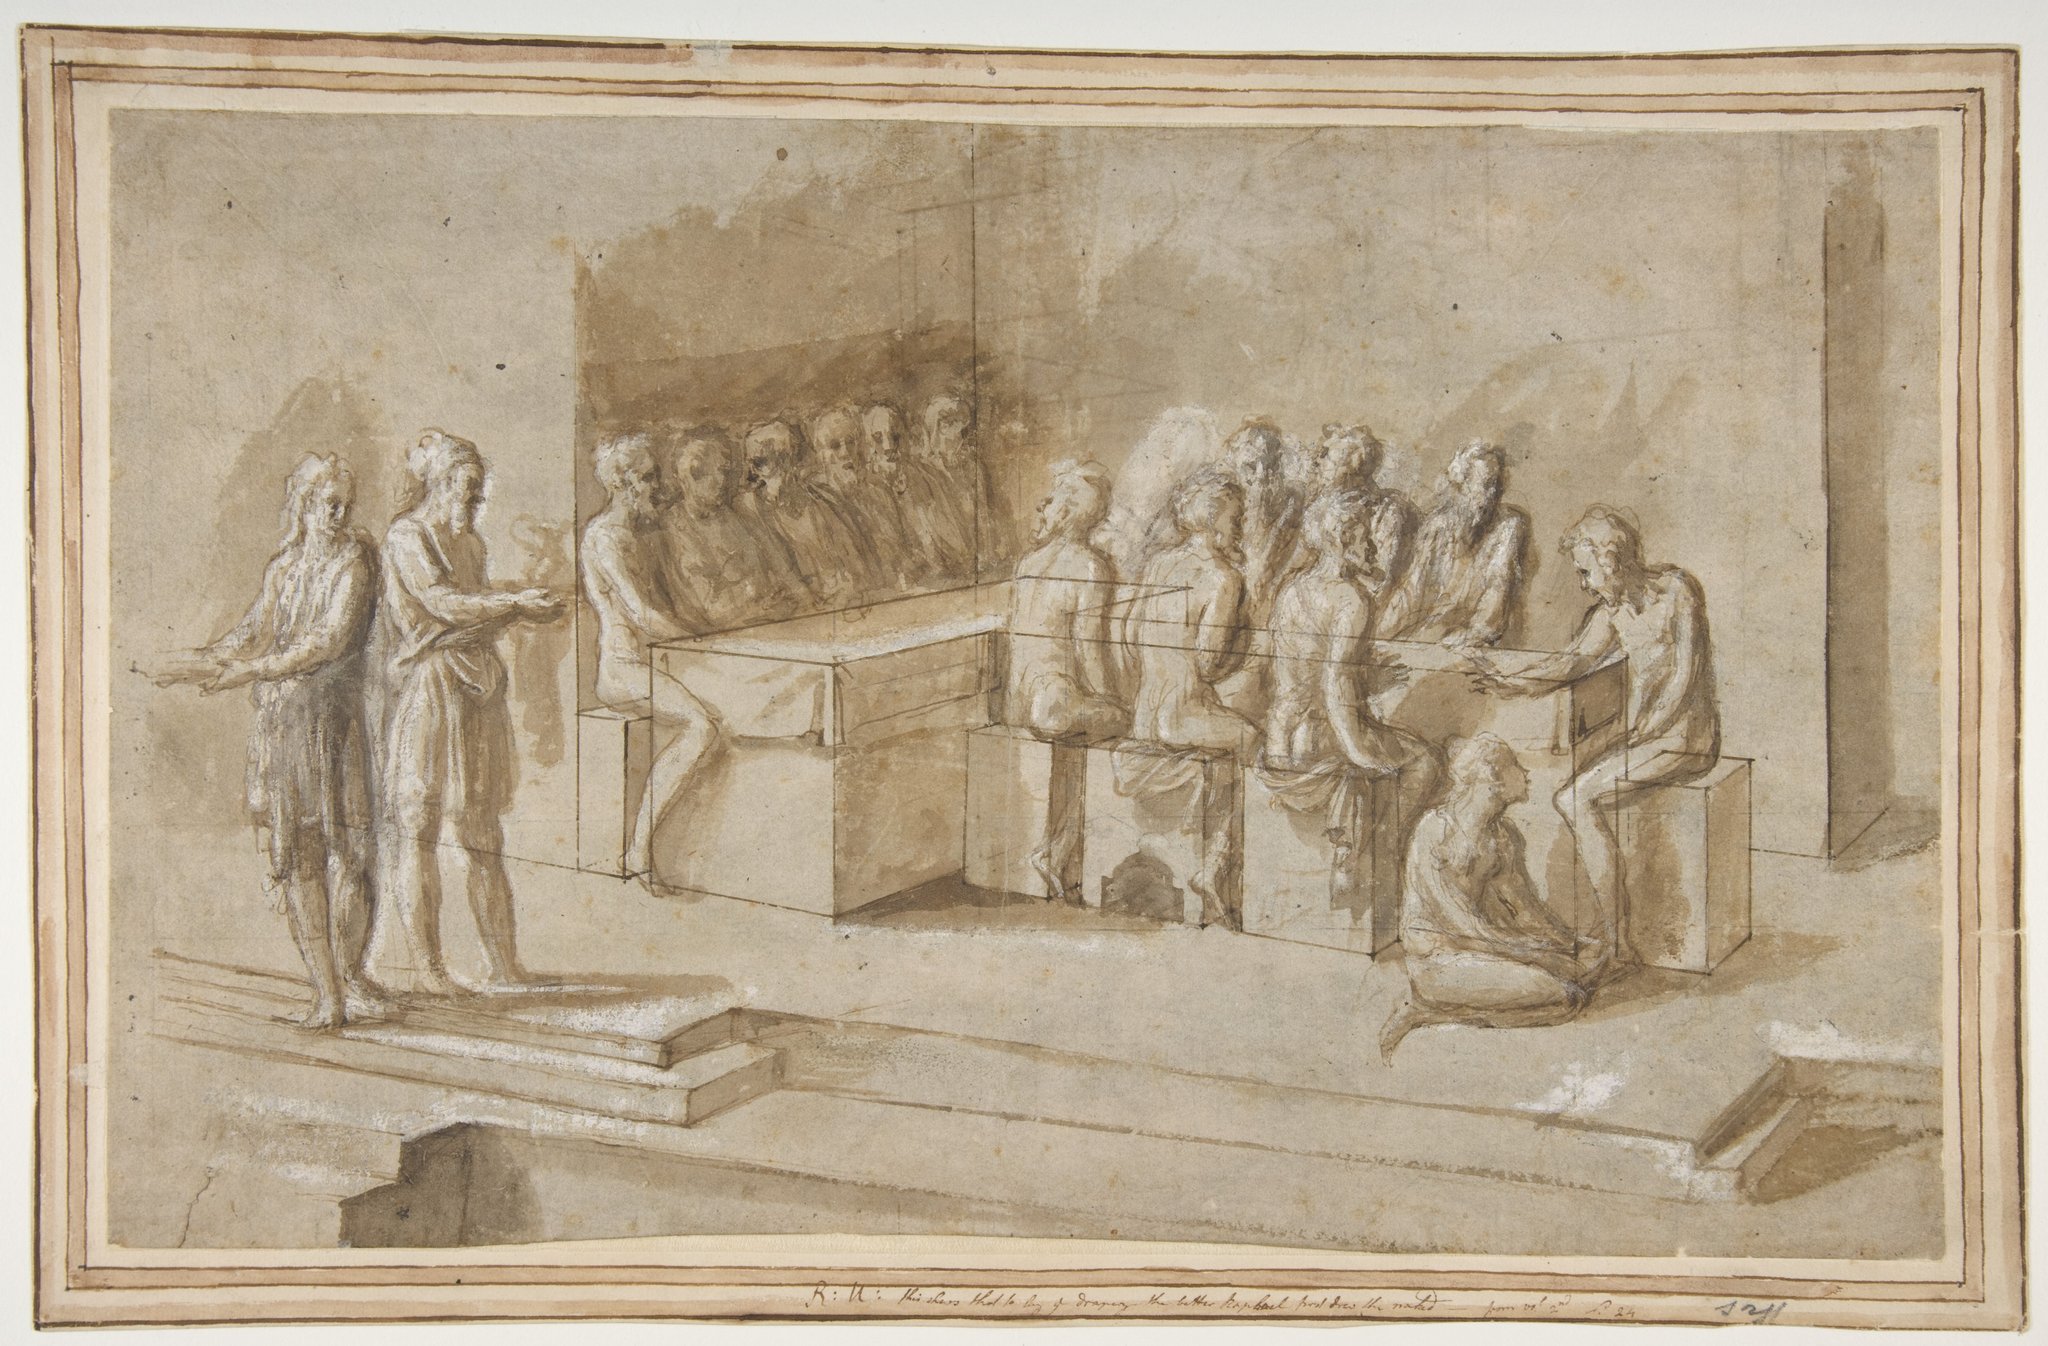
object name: drawing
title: Penitent Woman Anointing the Feet of Christ at the Table of Simon the Pharisee (Luke 7:36-50)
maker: biagio pupini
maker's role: artist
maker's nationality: italian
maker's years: 1511-1551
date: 1511-1551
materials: charcoal, ink, paper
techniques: brush, highlighting, pen, transfer, wash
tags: men,women,christ